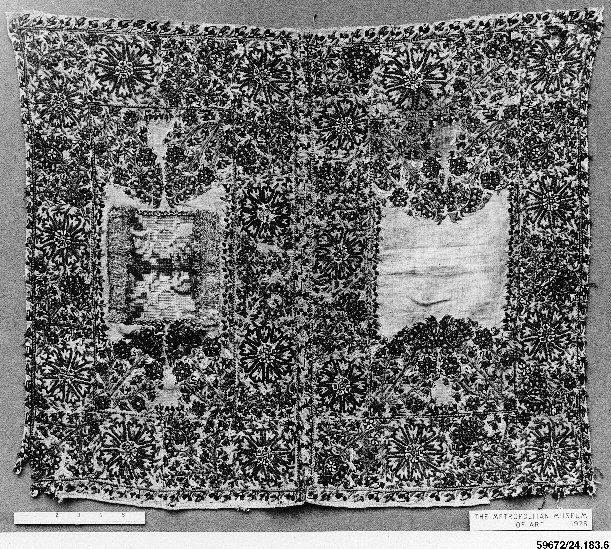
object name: cushion cover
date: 1701-1800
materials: linen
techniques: embroidery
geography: greece